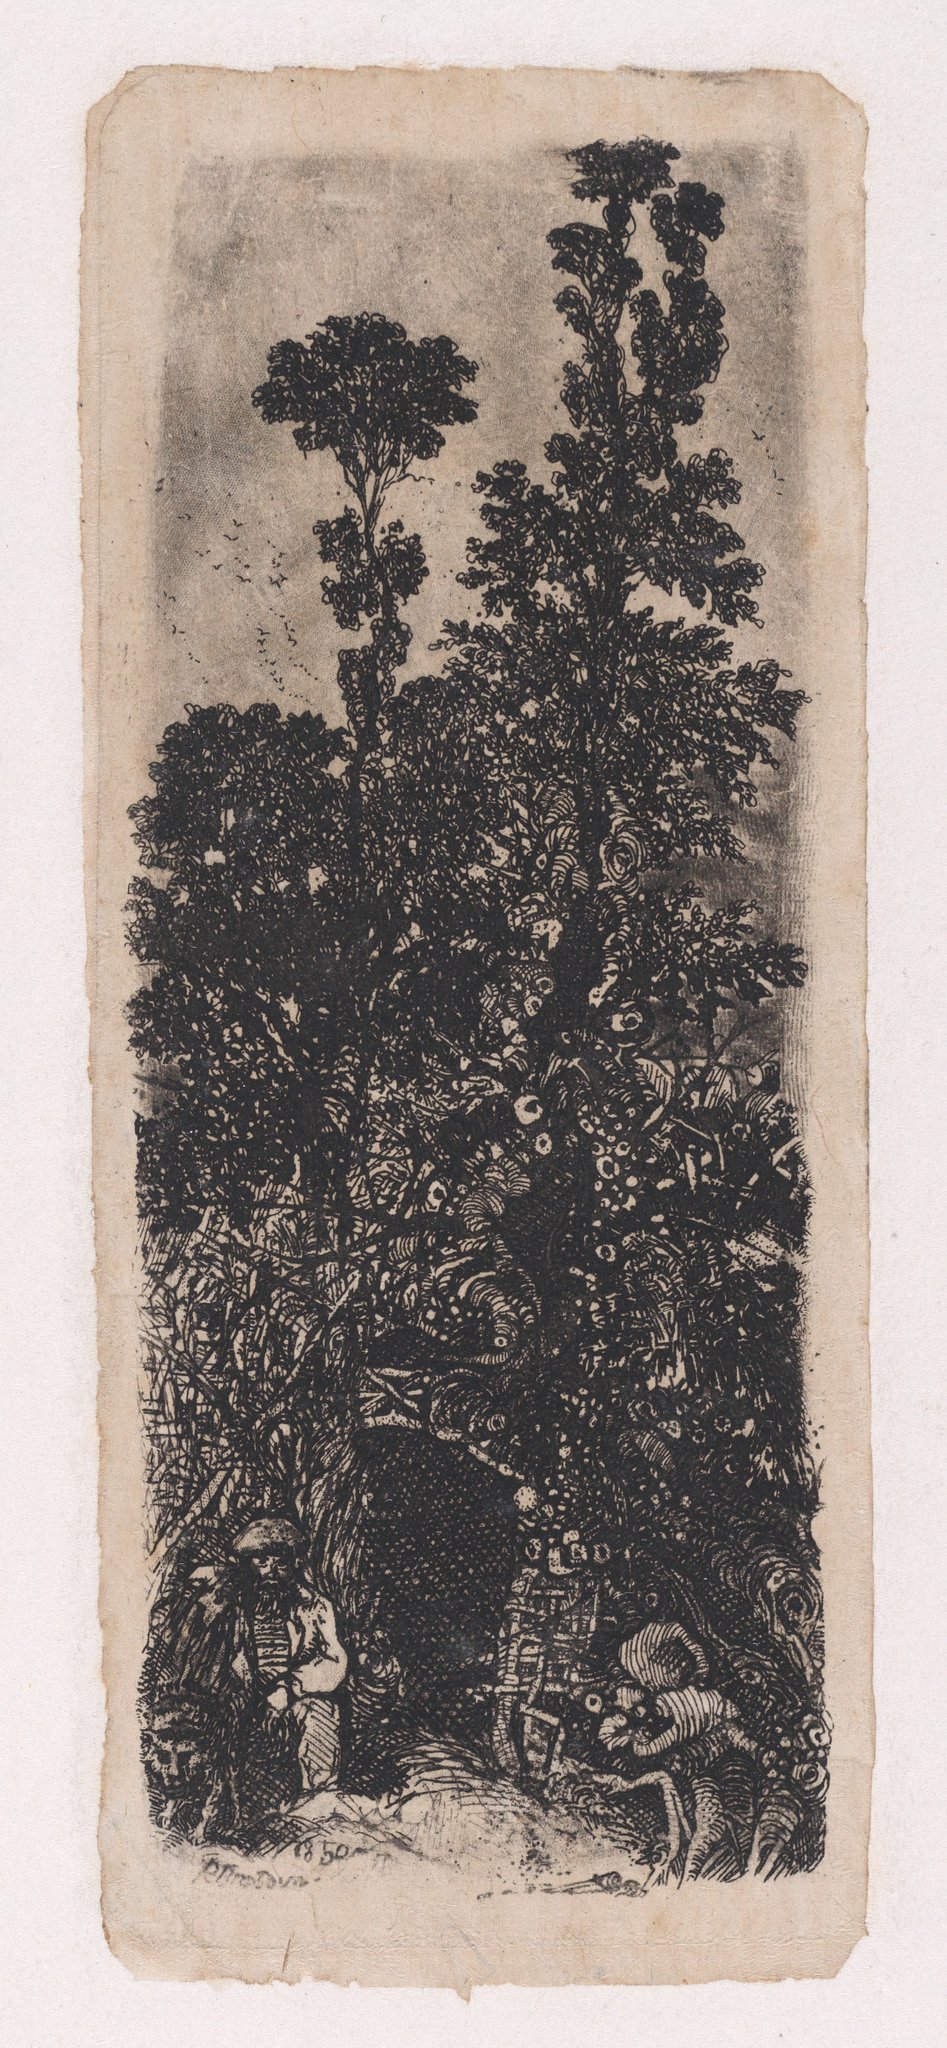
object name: print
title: L'Ermite Sous Les Arbres (The Hermit Under The Trees)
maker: rodolphe bresdin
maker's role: artist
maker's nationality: french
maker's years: 1822-1885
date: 1865-1866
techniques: etching